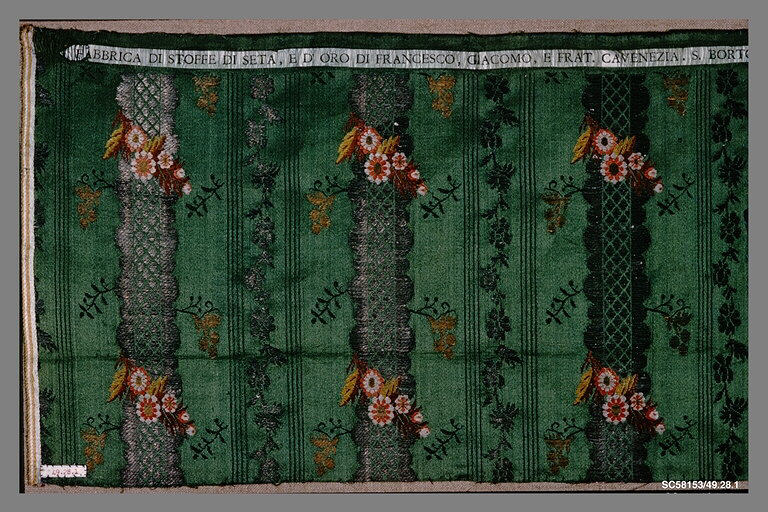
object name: piece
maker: cavenezia workshop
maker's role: maker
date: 1767-1800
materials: metal thread, silk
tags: flowers